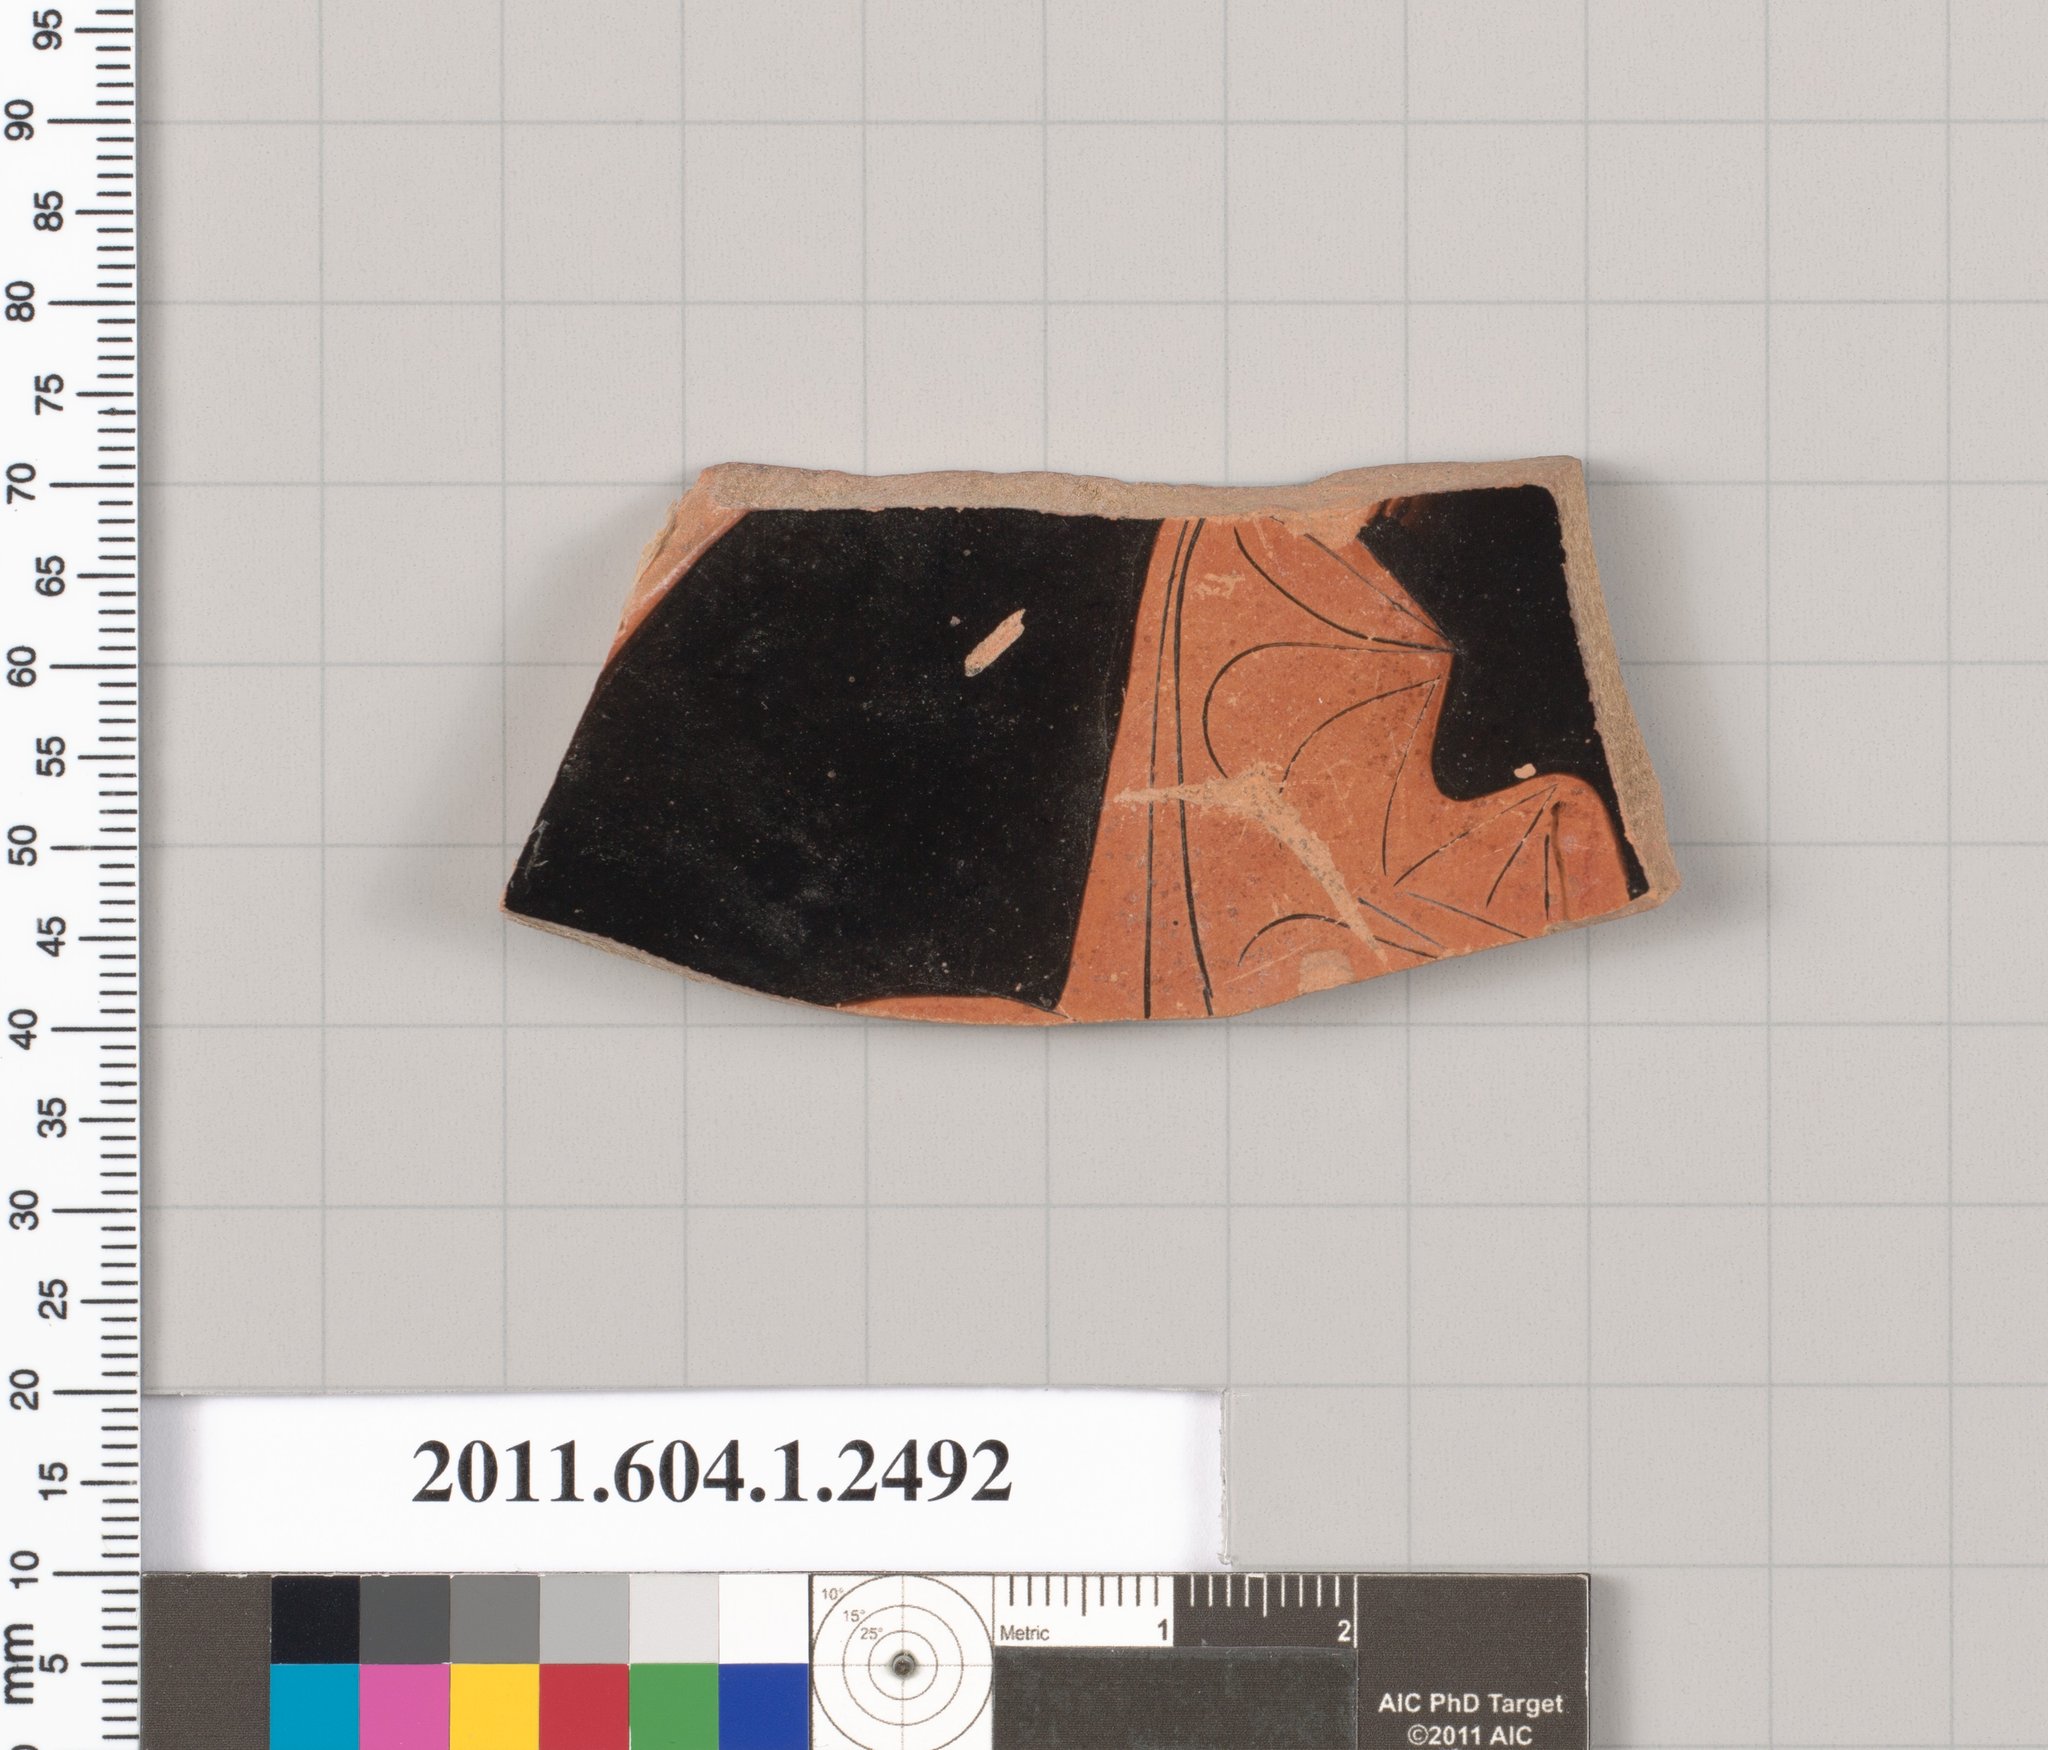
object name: kylix fragment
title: Terracotta fragment of a kylix (drinking cup)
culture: greek, attic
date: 475-451 BCE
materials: terracotta